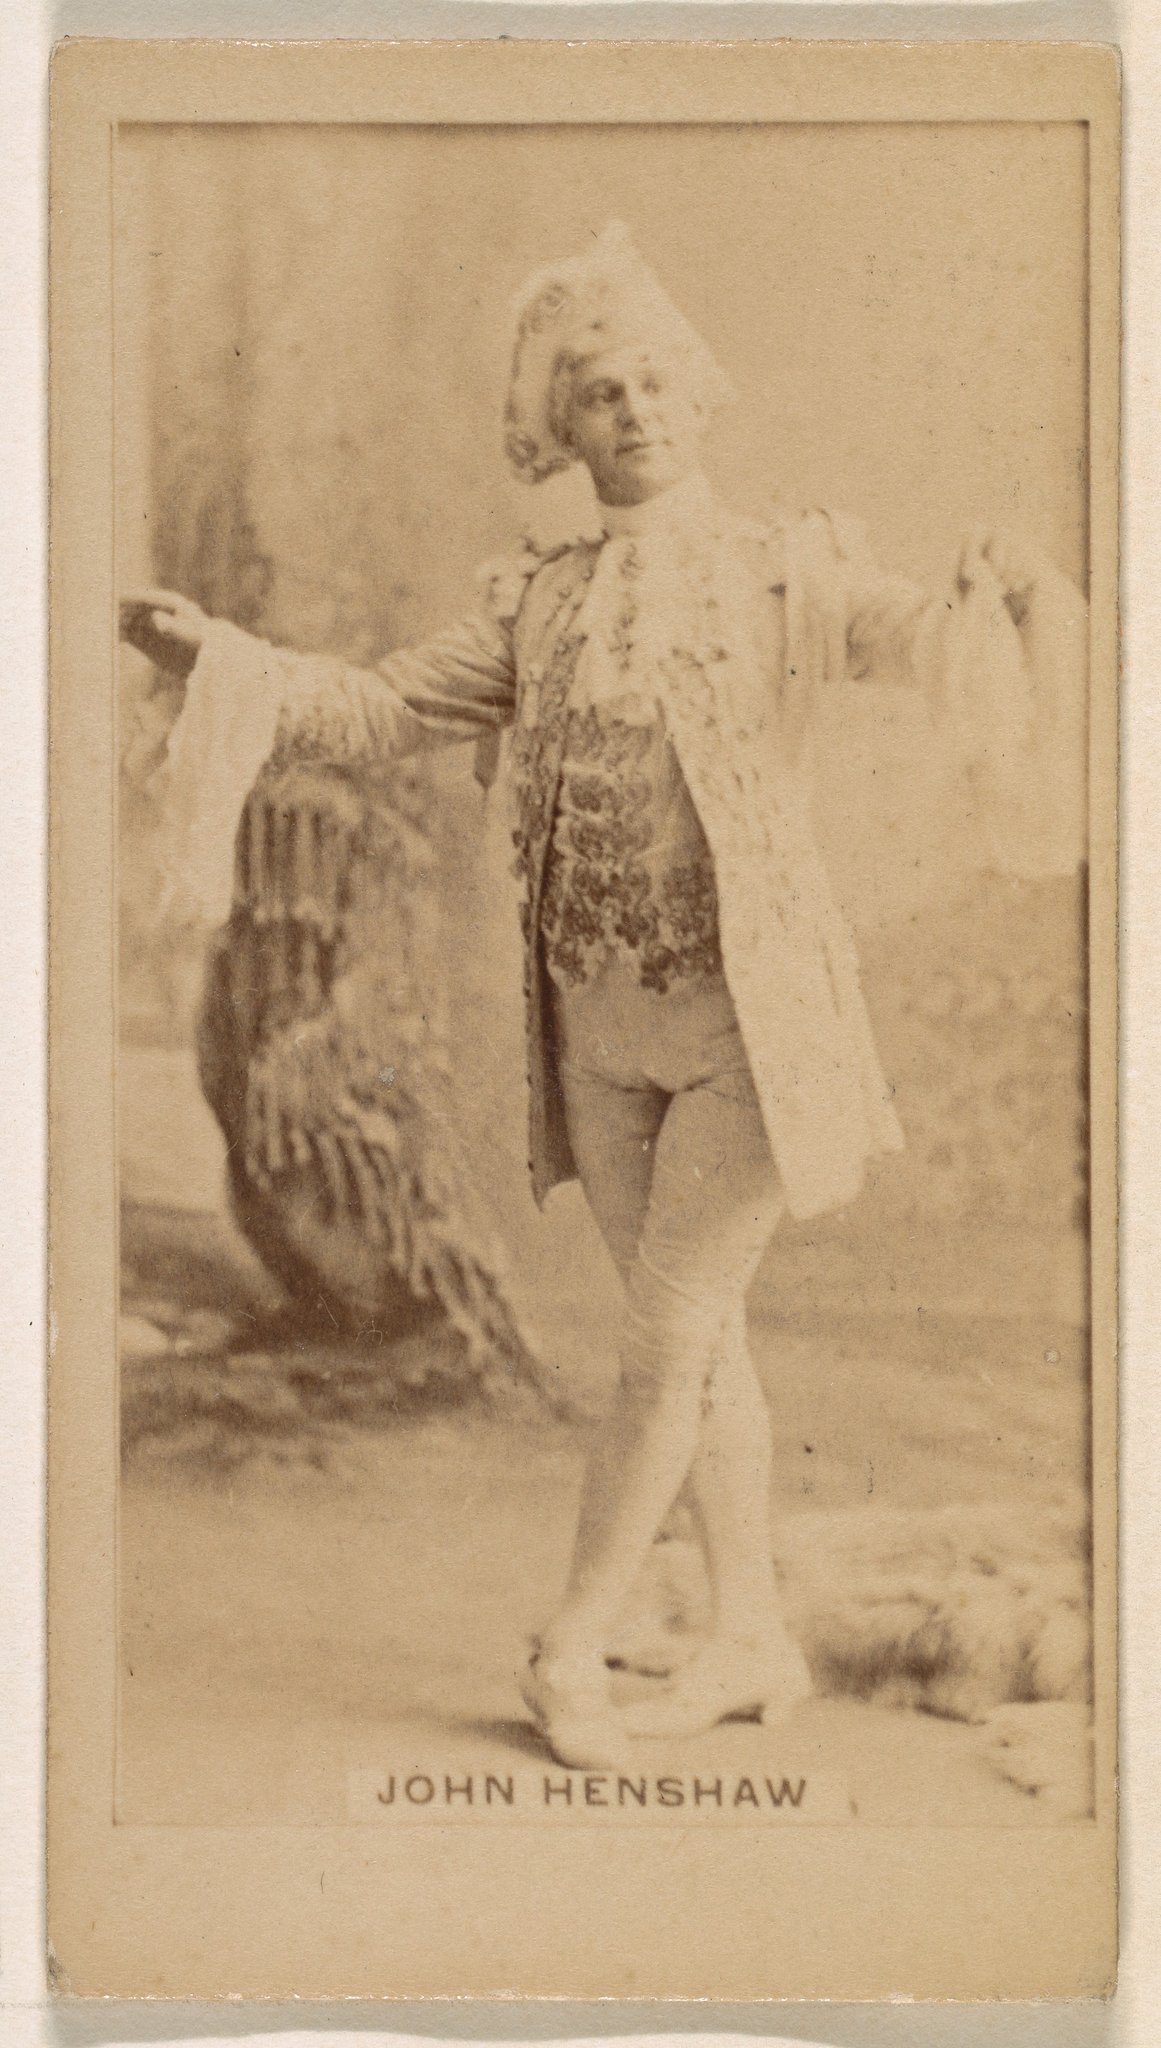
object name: photograph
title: John Henshaw, from the Actresses series (N245) issued by Kinney Brothers to promote Sweet Caporal Cigarettes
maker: kinney brothers tobacco company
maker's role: publisher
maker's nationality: american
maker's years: 1869-2011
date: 1890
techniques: albumen silver print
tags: men,portraits,actors